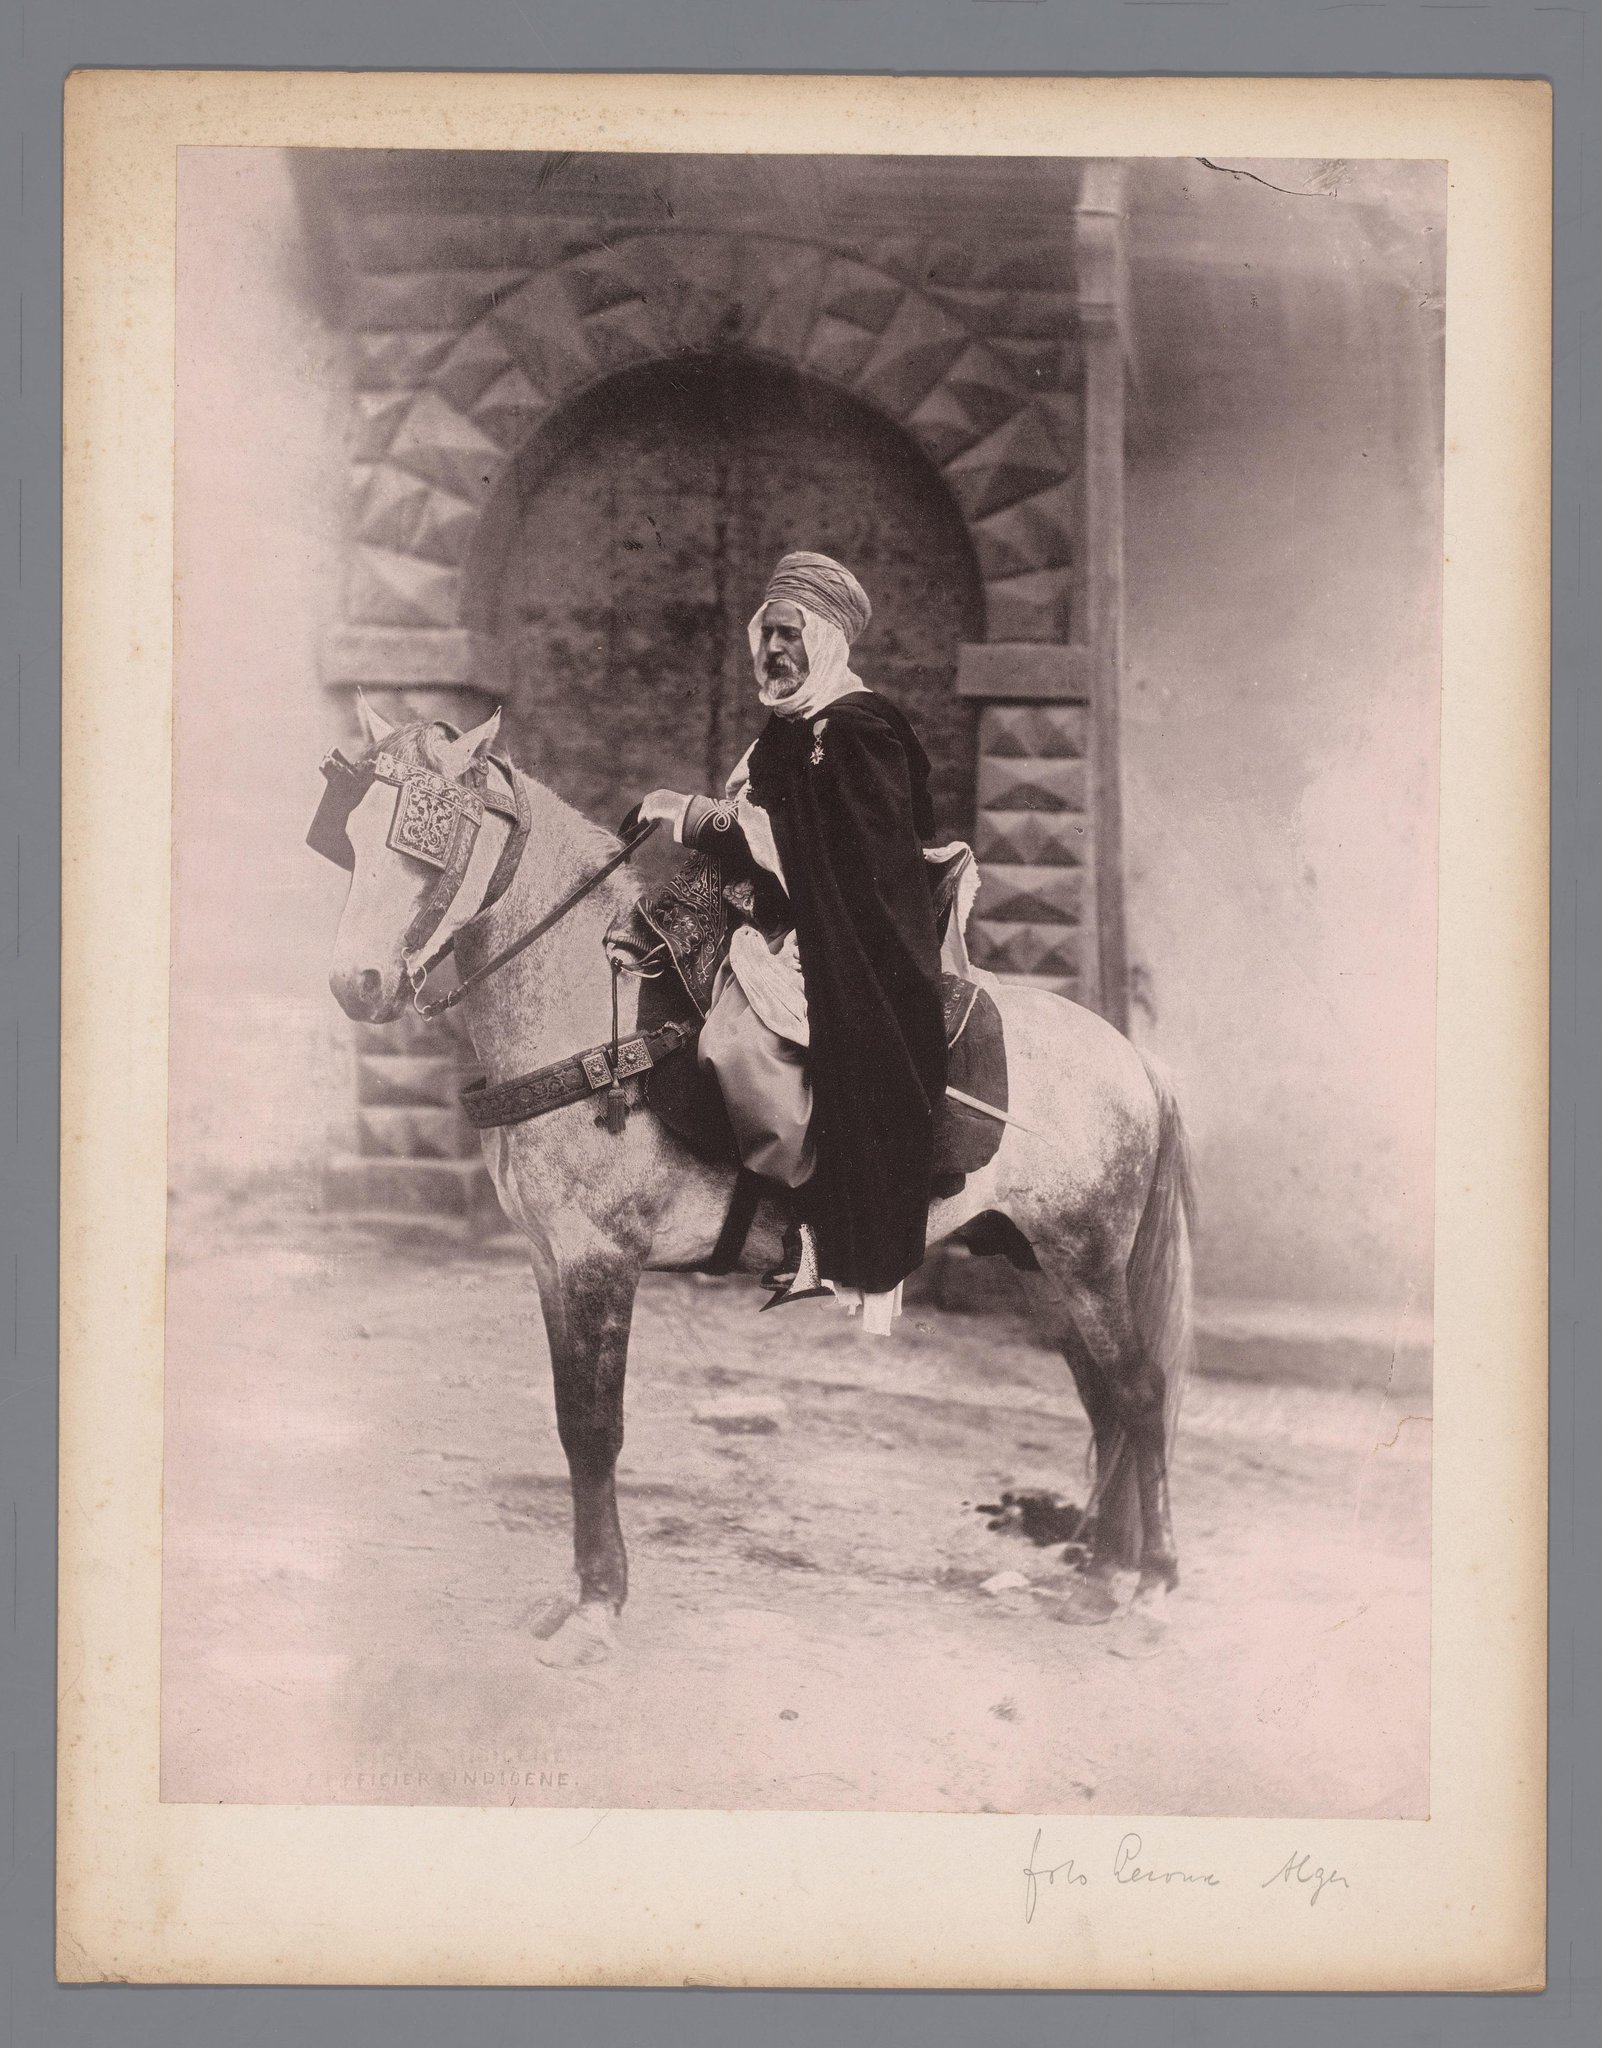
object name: photomechanical print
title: Officier te paard, vermoedelijk in Algiers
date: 1880-1900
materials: cardboard, paper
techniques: photograph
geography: algiers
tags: riding a horse, ass, or mule; rider, horseman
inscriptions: inscription: ‘foto Leroux Alger’